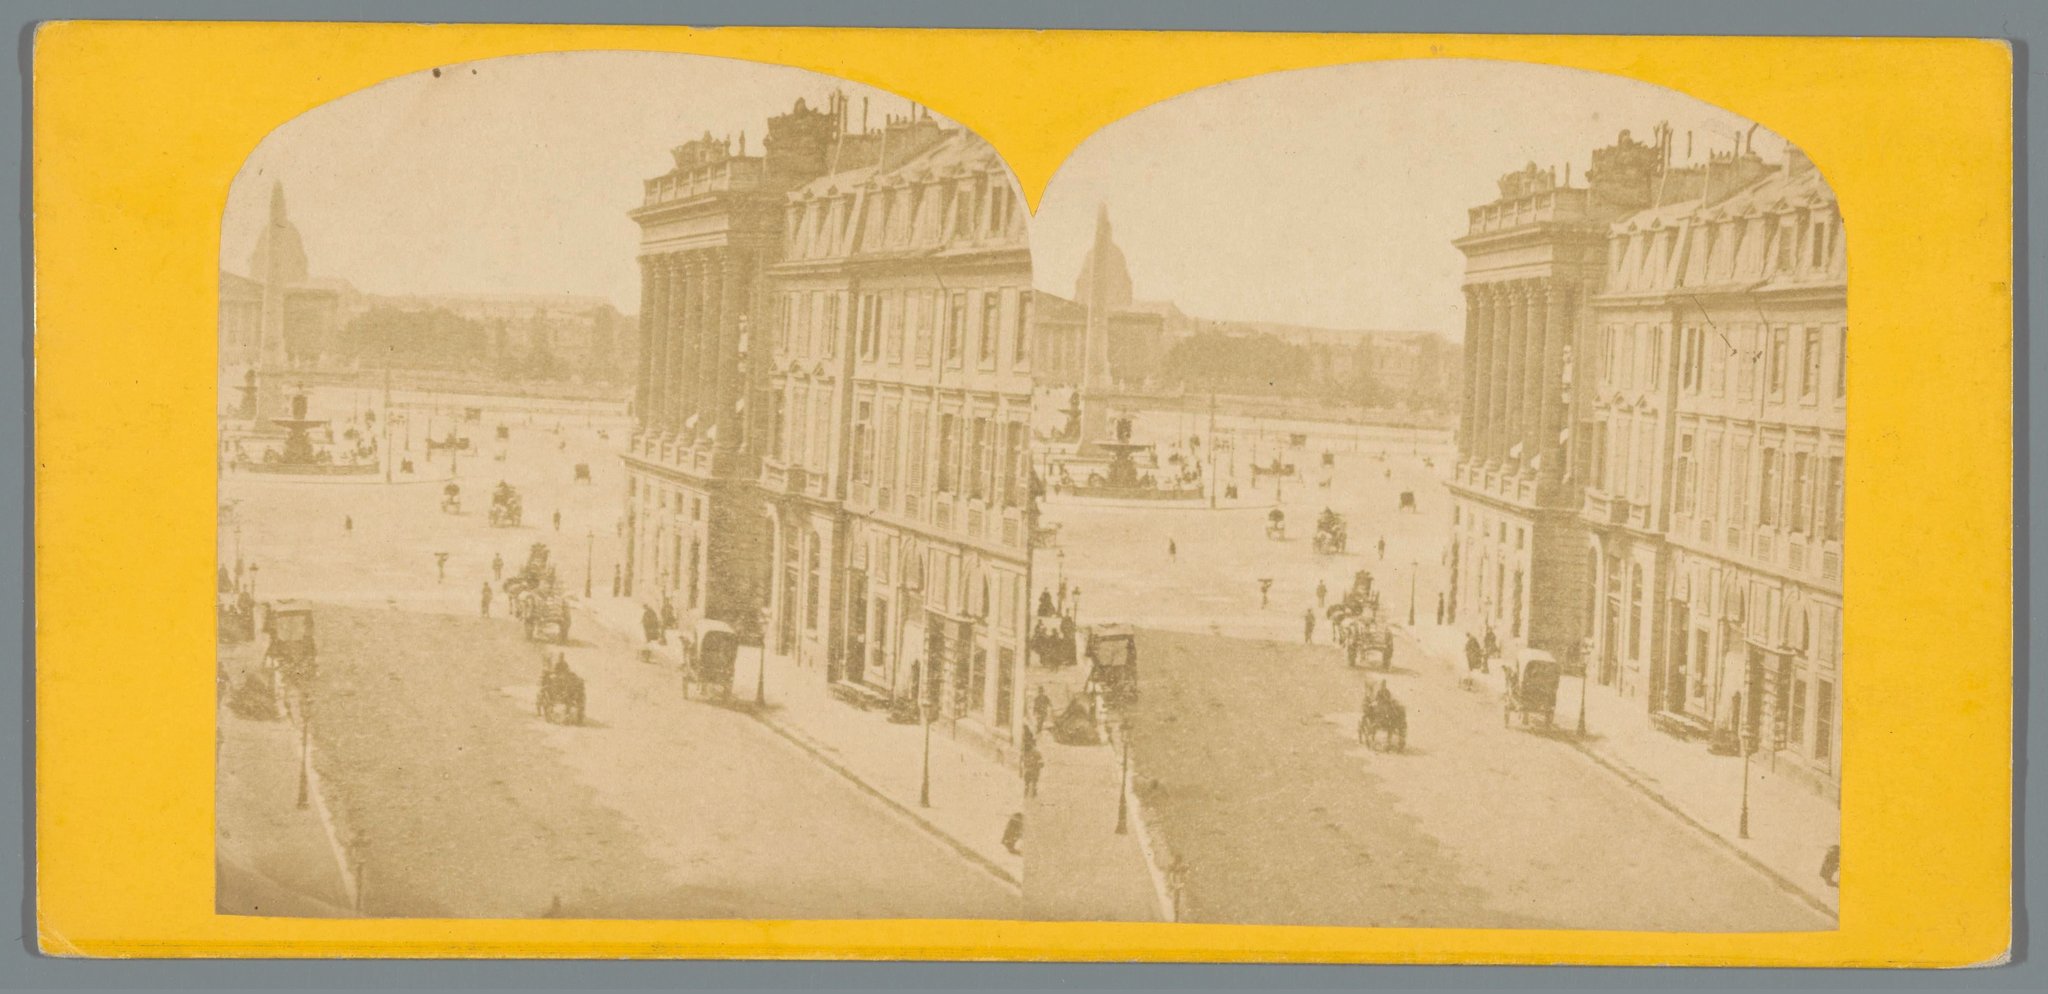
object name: stereograph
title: Gezicht op Place de la Concorde vanuit de Rue Royale in Parijs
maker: Anonymous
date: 1850-1880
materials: cardboard, photographic support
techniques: albumen print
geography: paris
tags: square, place, circus, etc., obelisk, needle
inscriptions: number: ‘No. 58’, inscription: ‘rue Royale Paris’